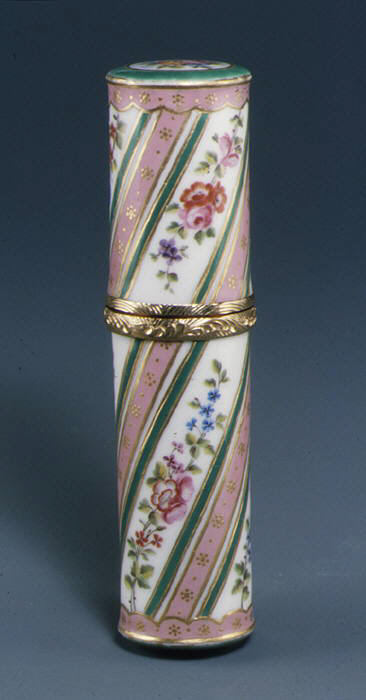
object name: needle case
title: Needle case (étui)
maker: sèvres manufactory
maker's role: manufactory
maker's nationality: french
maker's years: 1740-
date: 1757-1758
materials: gold, soft paste porcelain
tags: flowers